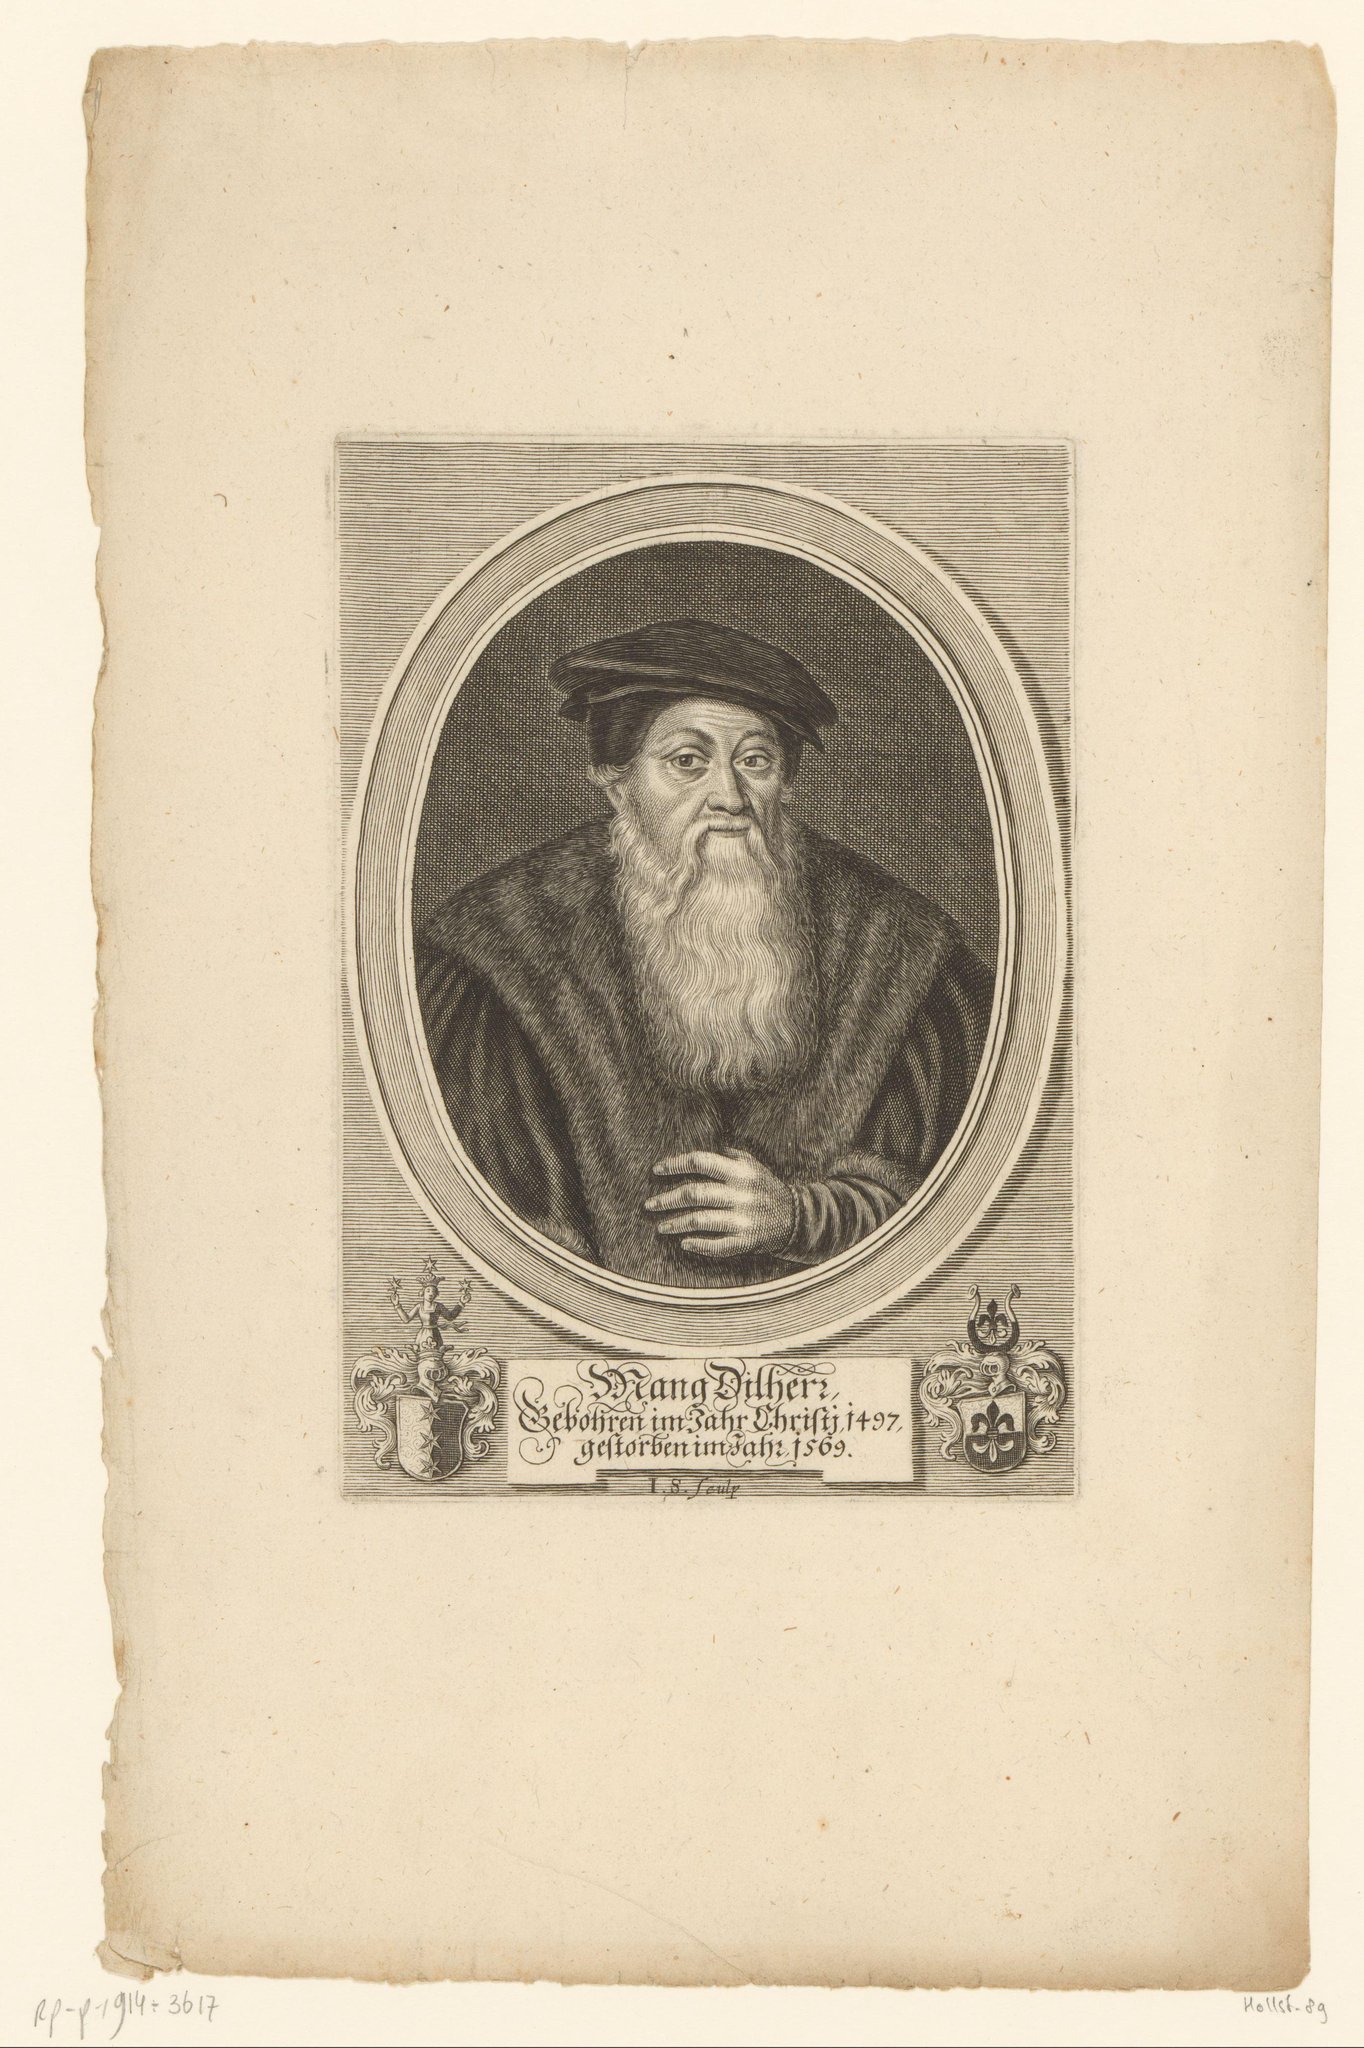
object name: print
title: Portret van Magnus Dilherr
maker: jakob von sandrart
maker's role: print maker, publisher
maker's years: 1630-1708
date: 1656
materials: paper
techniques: engraving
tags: historical persons, armorial bearing, heraldry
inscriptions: collector's mark: Lugt 2228